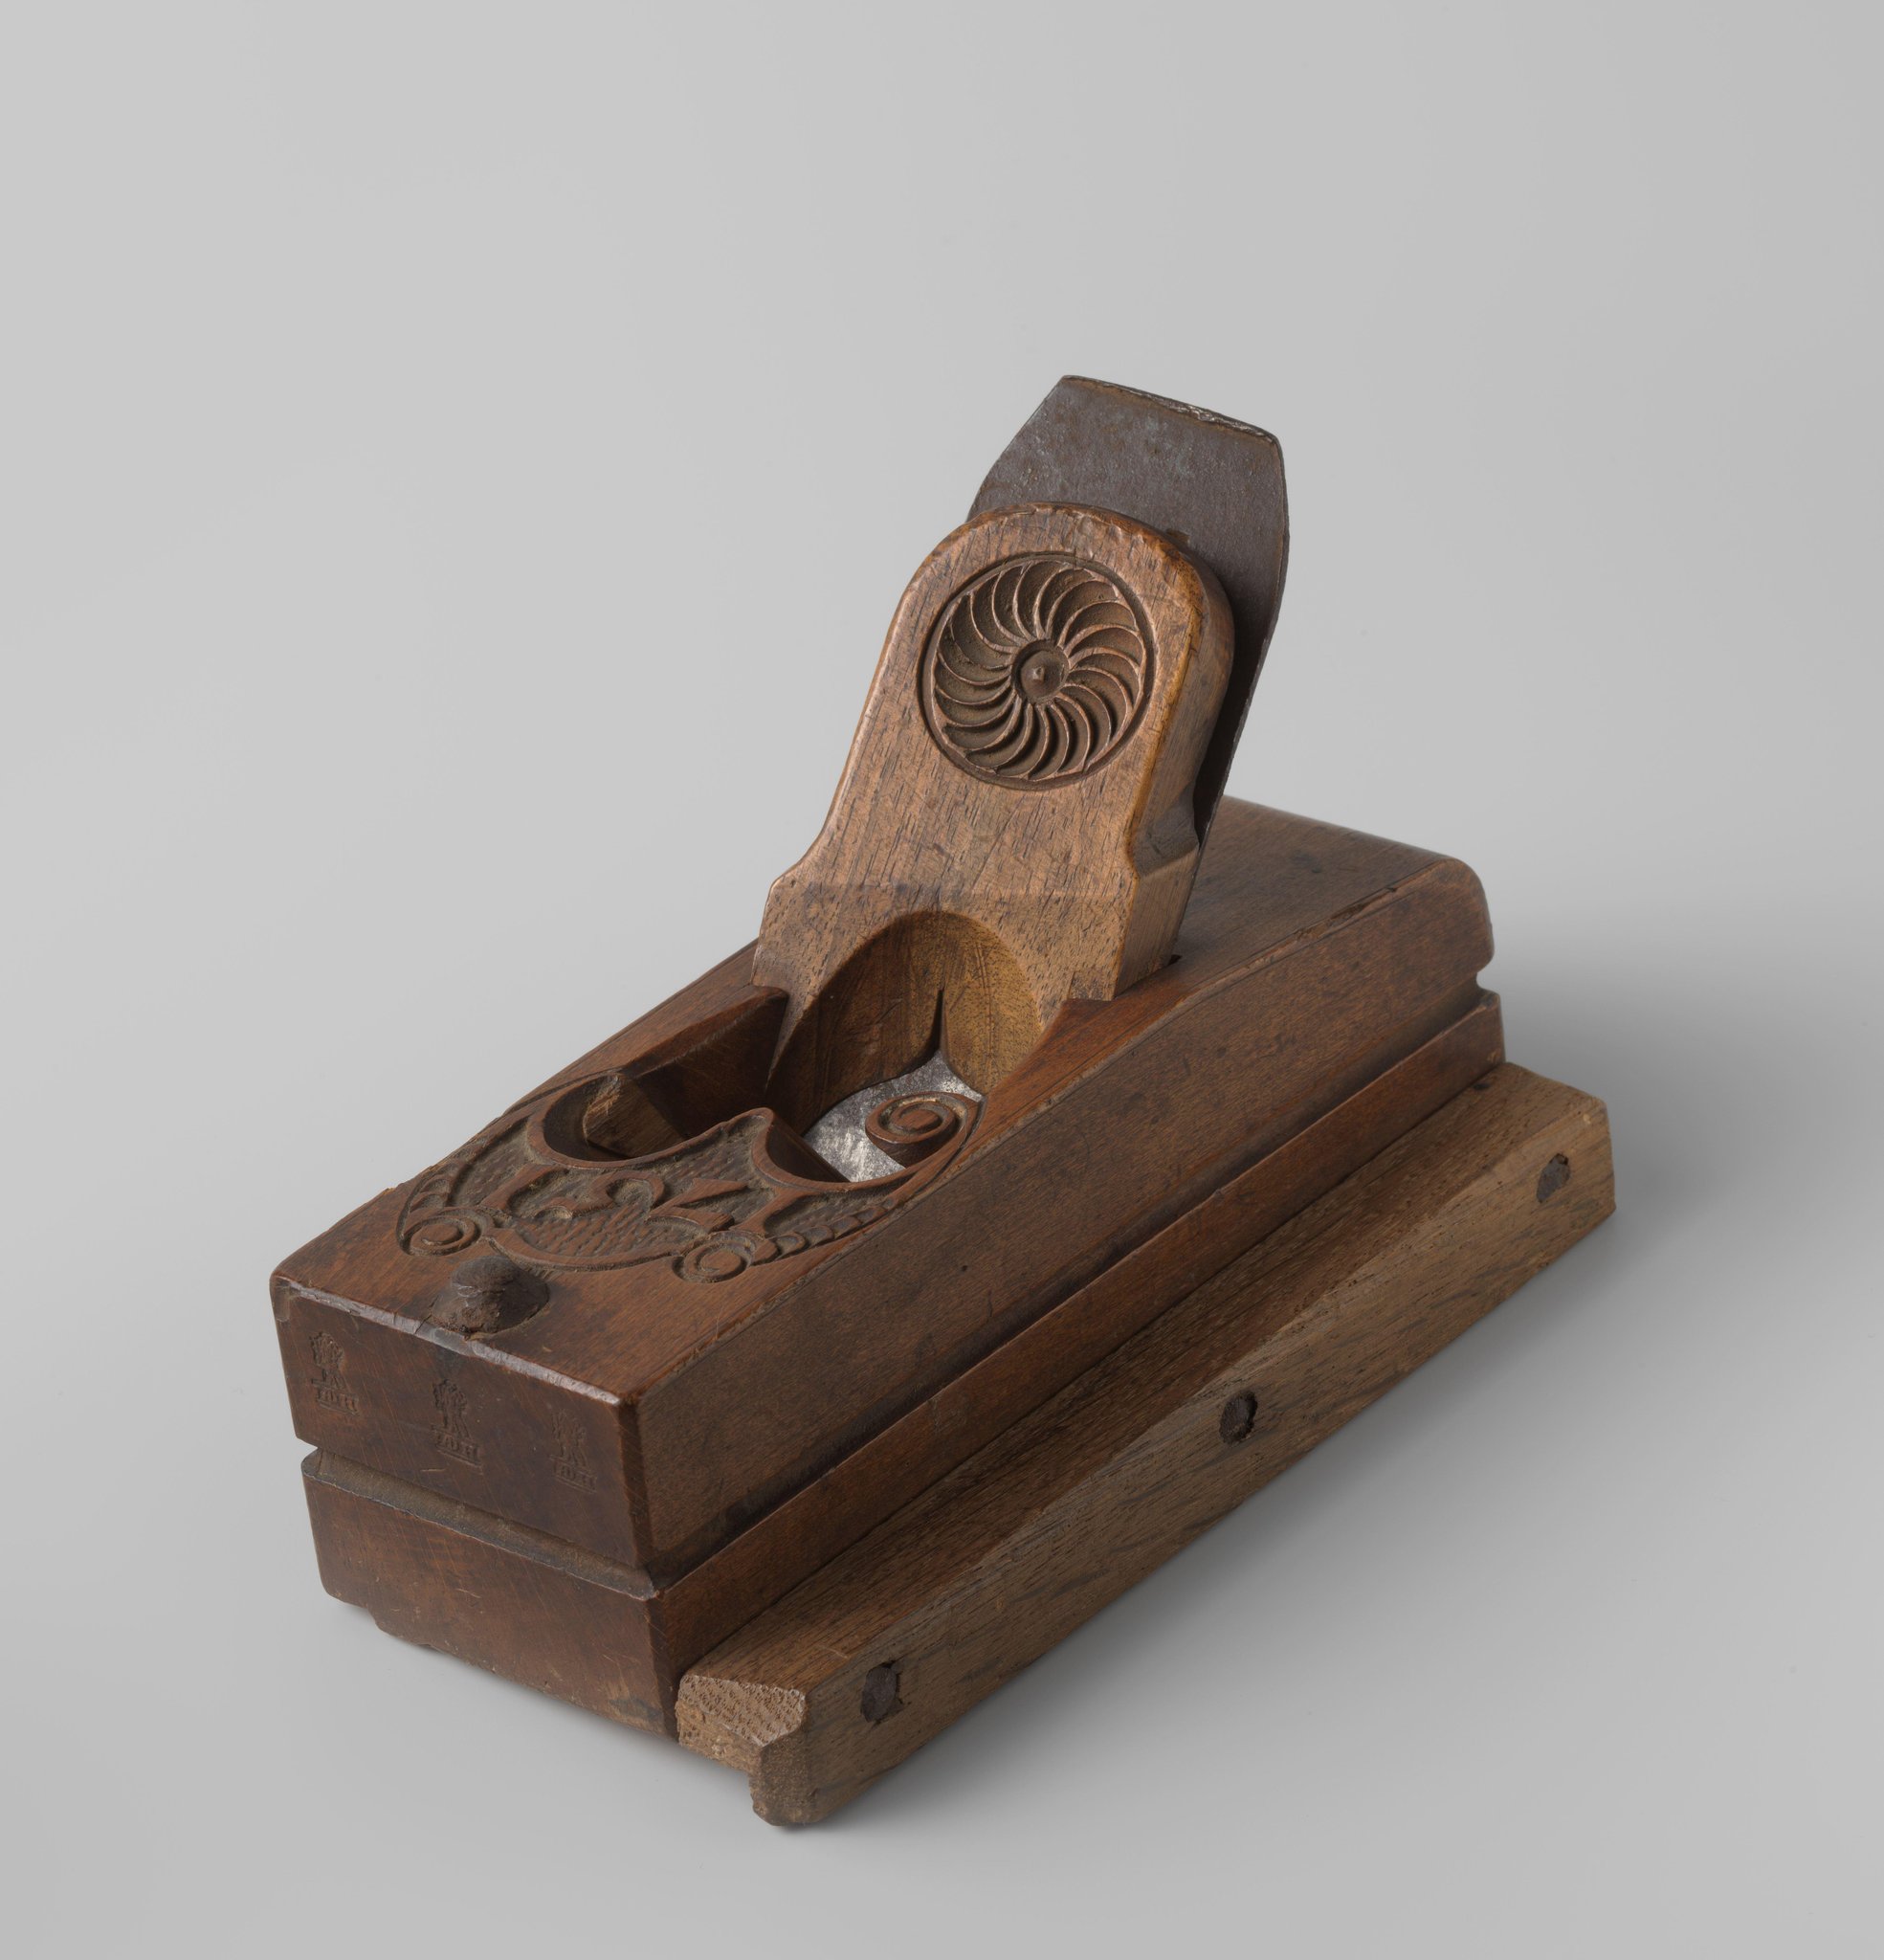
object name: block plane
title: Sponningschaaf met snijwerk en jaartal 1751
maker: Anonymous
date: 1751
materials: wood, iron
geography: netherlands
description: Sponningschaaf met snijwerk en jaartal 1751. Ingericht als bossingschaaf.